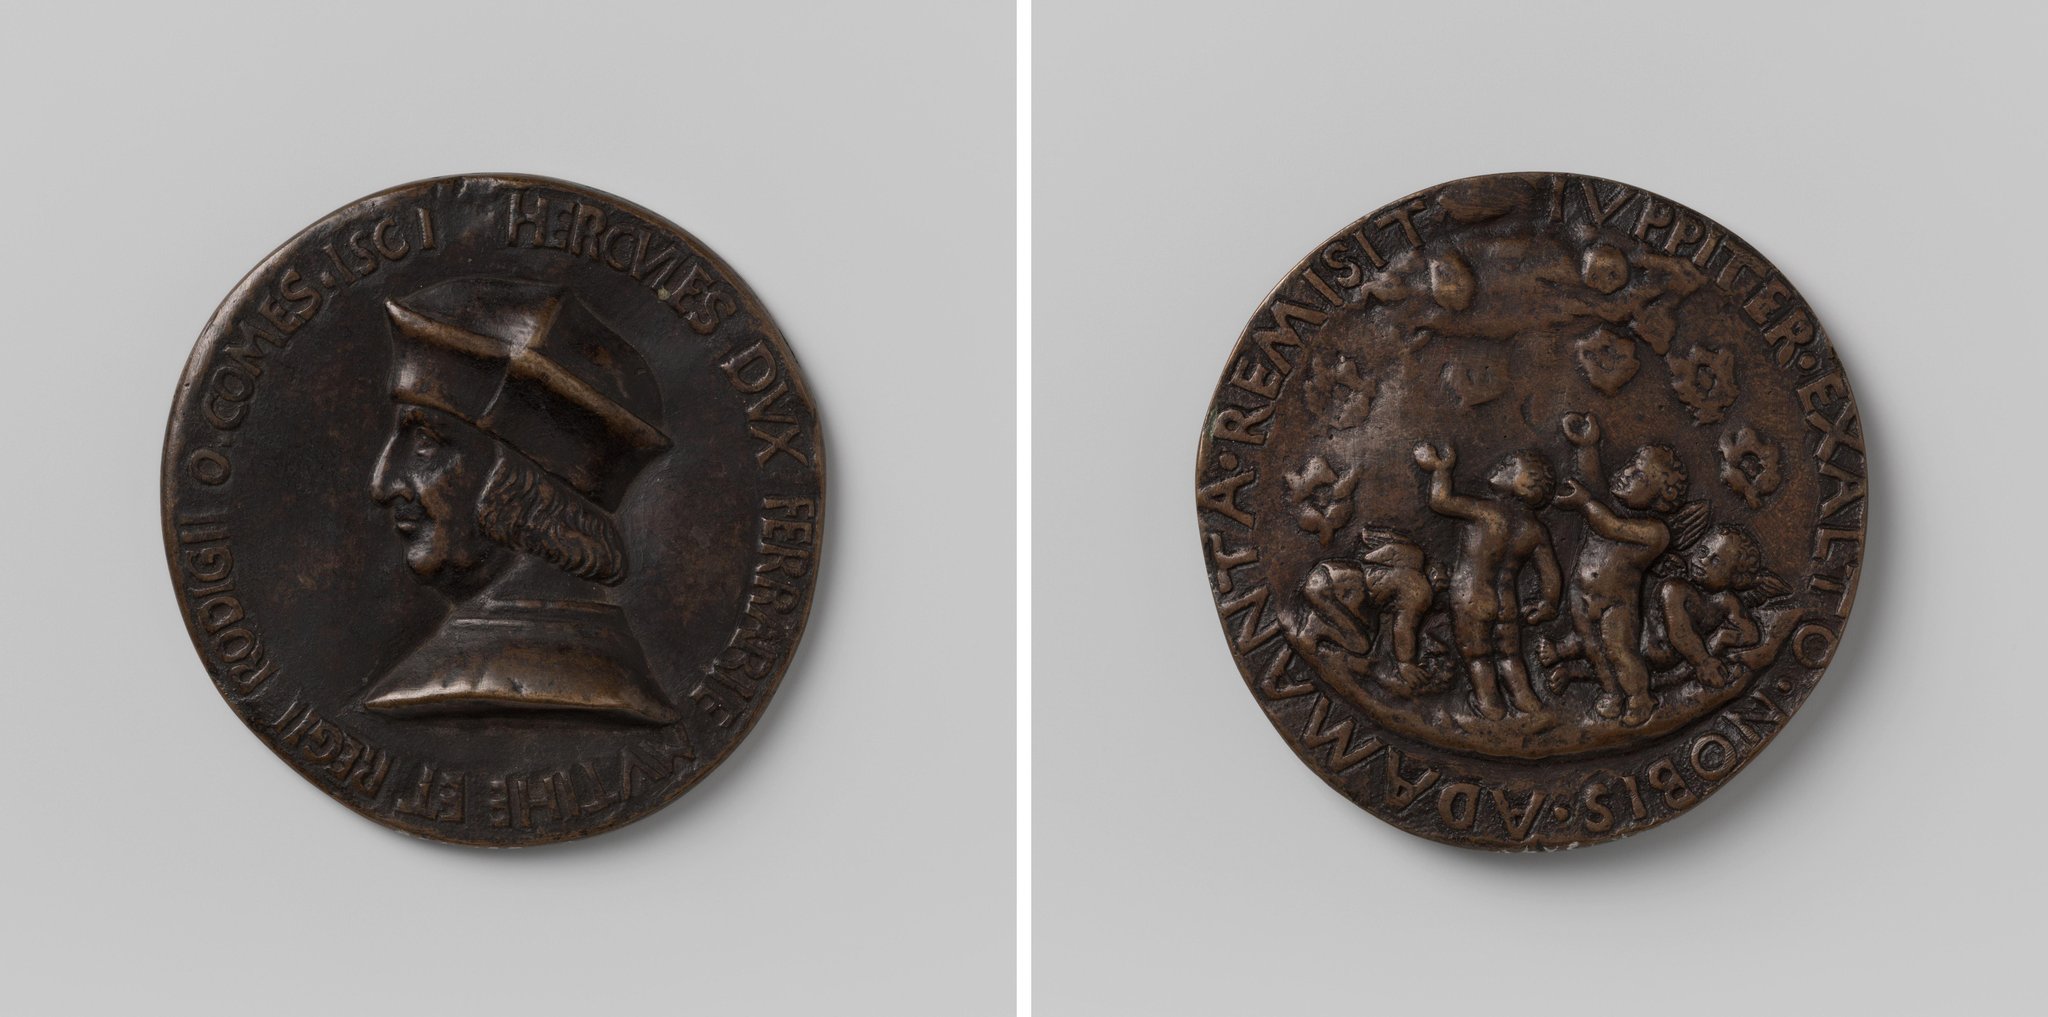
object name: medal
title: Portret van Hertog Hercules (Ercole d'Este) van Ferrara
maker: Anonymous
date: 1830-1900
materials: bronze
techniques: galvanoplasty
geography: italy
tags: hertog, ercole i di este (hertog van ferrara)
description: Galvanoplastische reproductie in brons van de portretmedaille van Hertog Hercules (Ercole d'Este) van Ferrara. Randscharift: HERCVLES DUX FERRARIE MVTIHE ET REGII RODIGII O.COMES.ISCI. Revers: vier naakte genii, waarvan drie gevleugeld, vangen en rapen van de grond vlammende voorwerpen. Randschrift: IVPPITER.EX ALTO.NOBIS.ADAMANTA.REMISIT. Naar een origineel uit 1497.